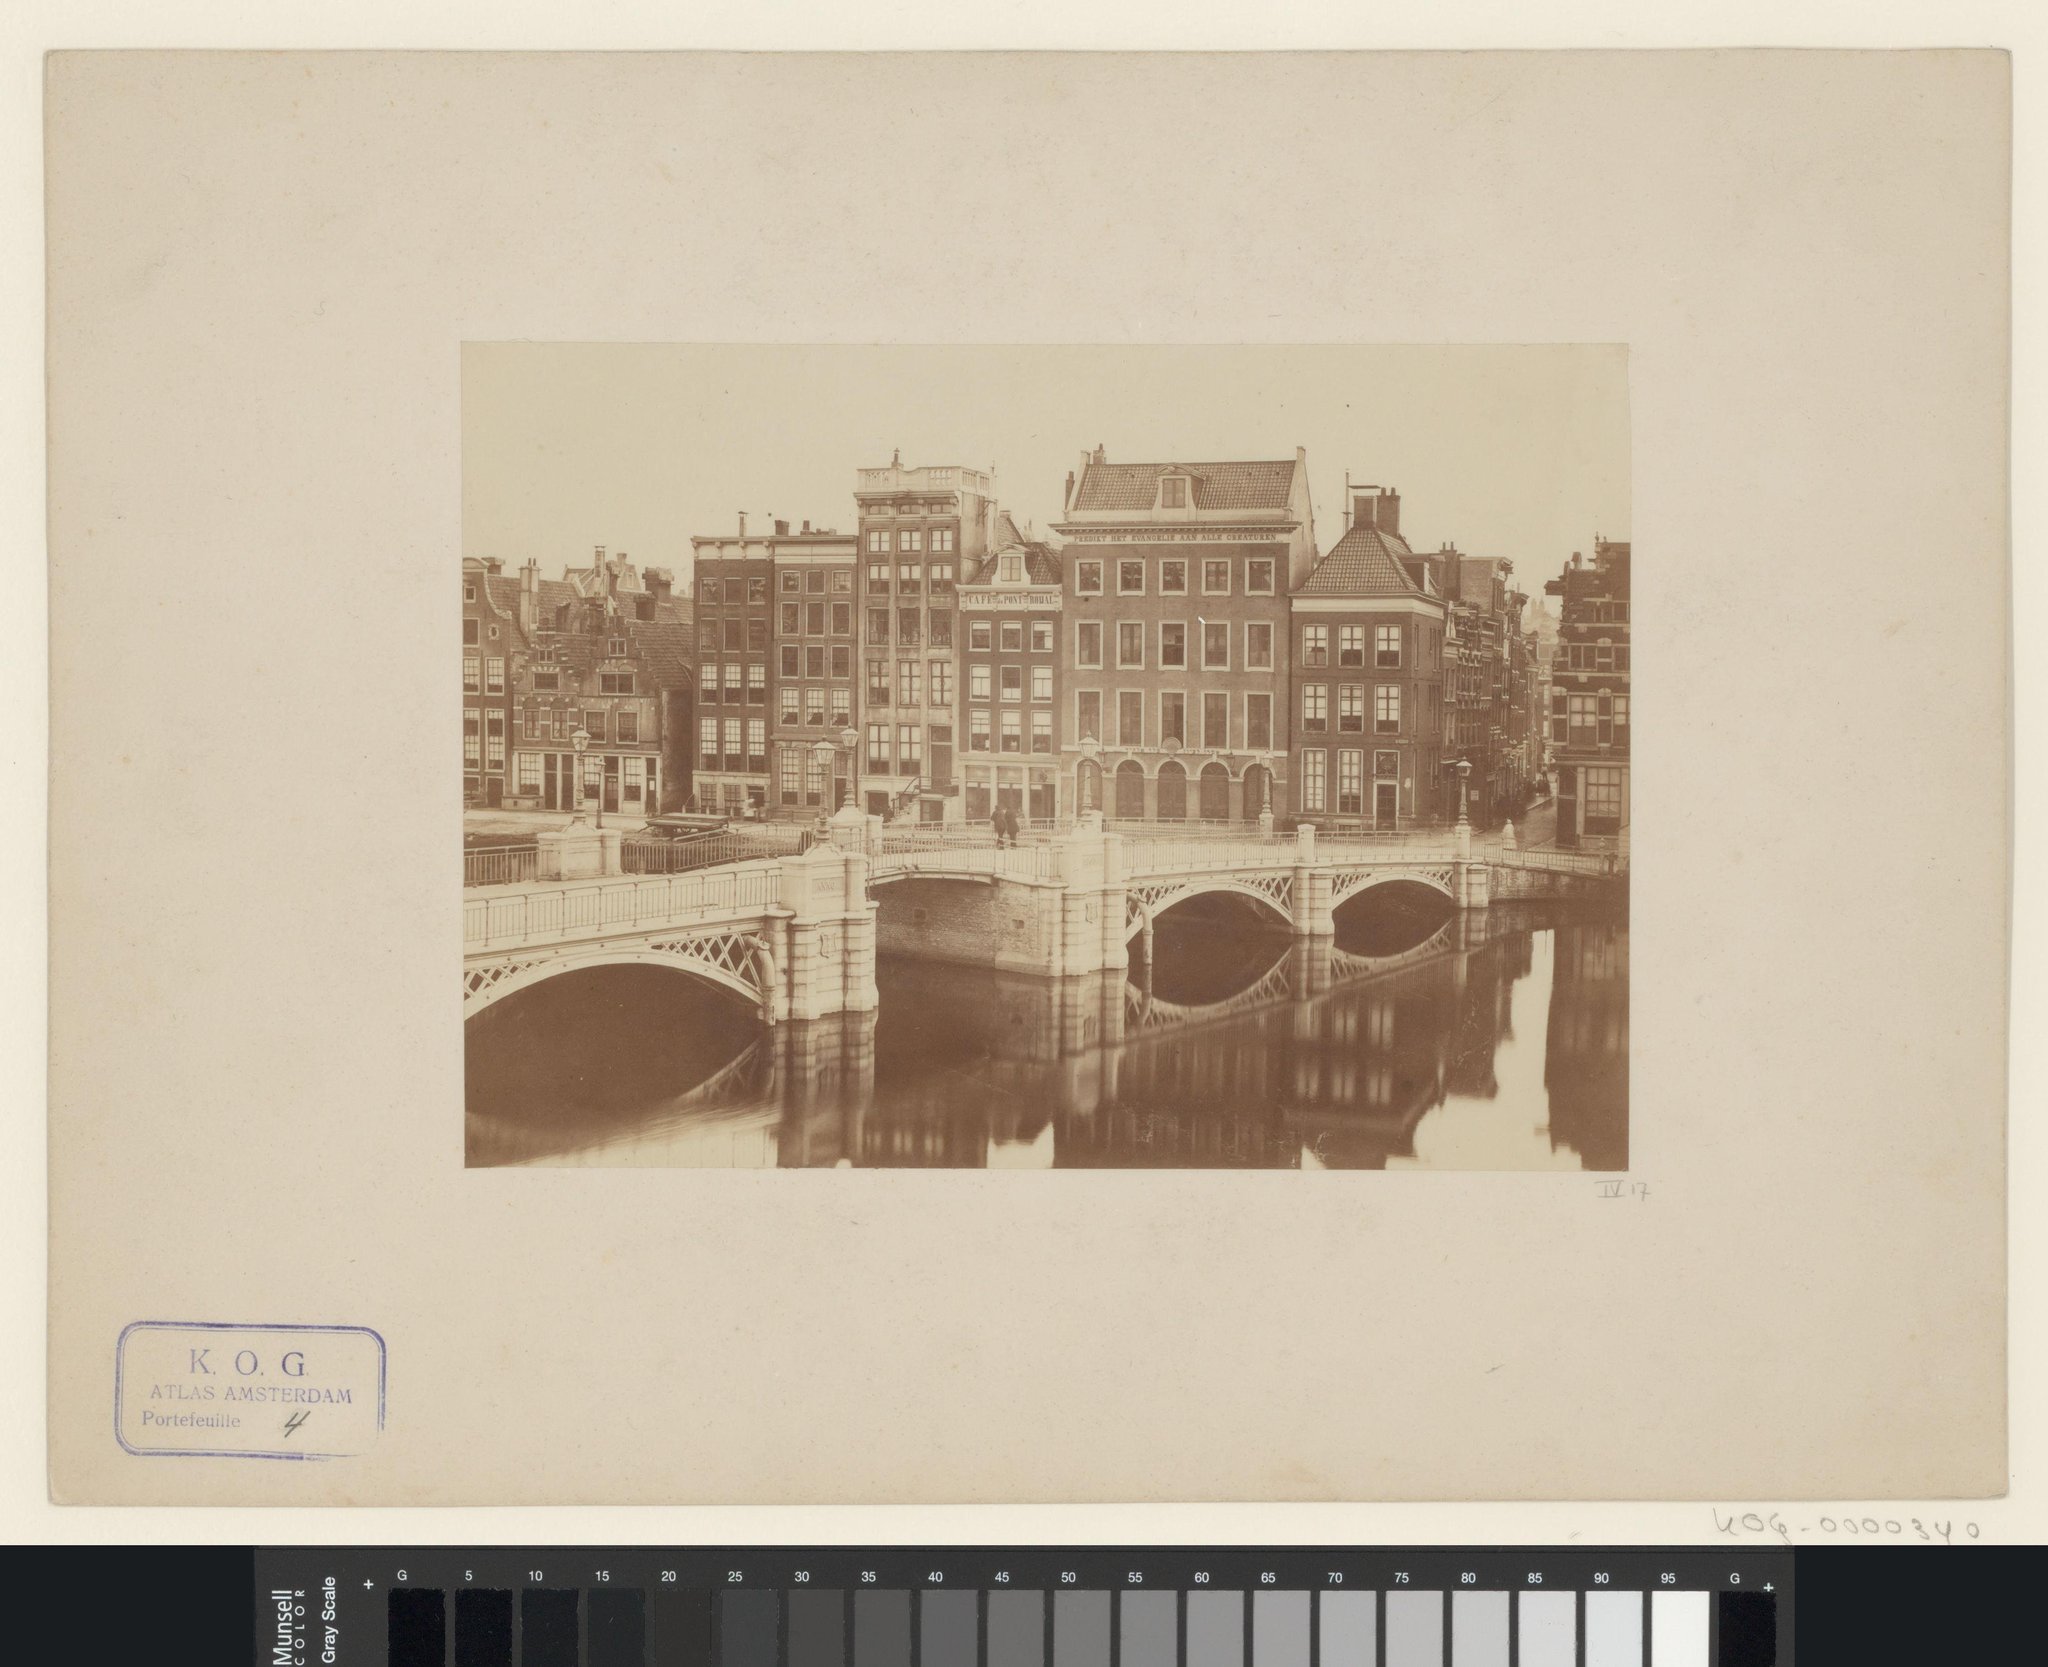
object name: photograph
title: Gezicht op de Halvemaansbrug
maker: Anonymous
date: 1863-1915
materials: cardboard, paper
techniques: albumen print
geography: amsterdam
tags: city-view in general; 'veduta', canal, bridge in city across river, canal, etc.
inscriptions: collector's mark: ‘4’ Lugt 1641b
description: Onderwerpsrubriek binnen de Atlas Amsterdam: Amstel van Doelensluis tot Blauwbrug.